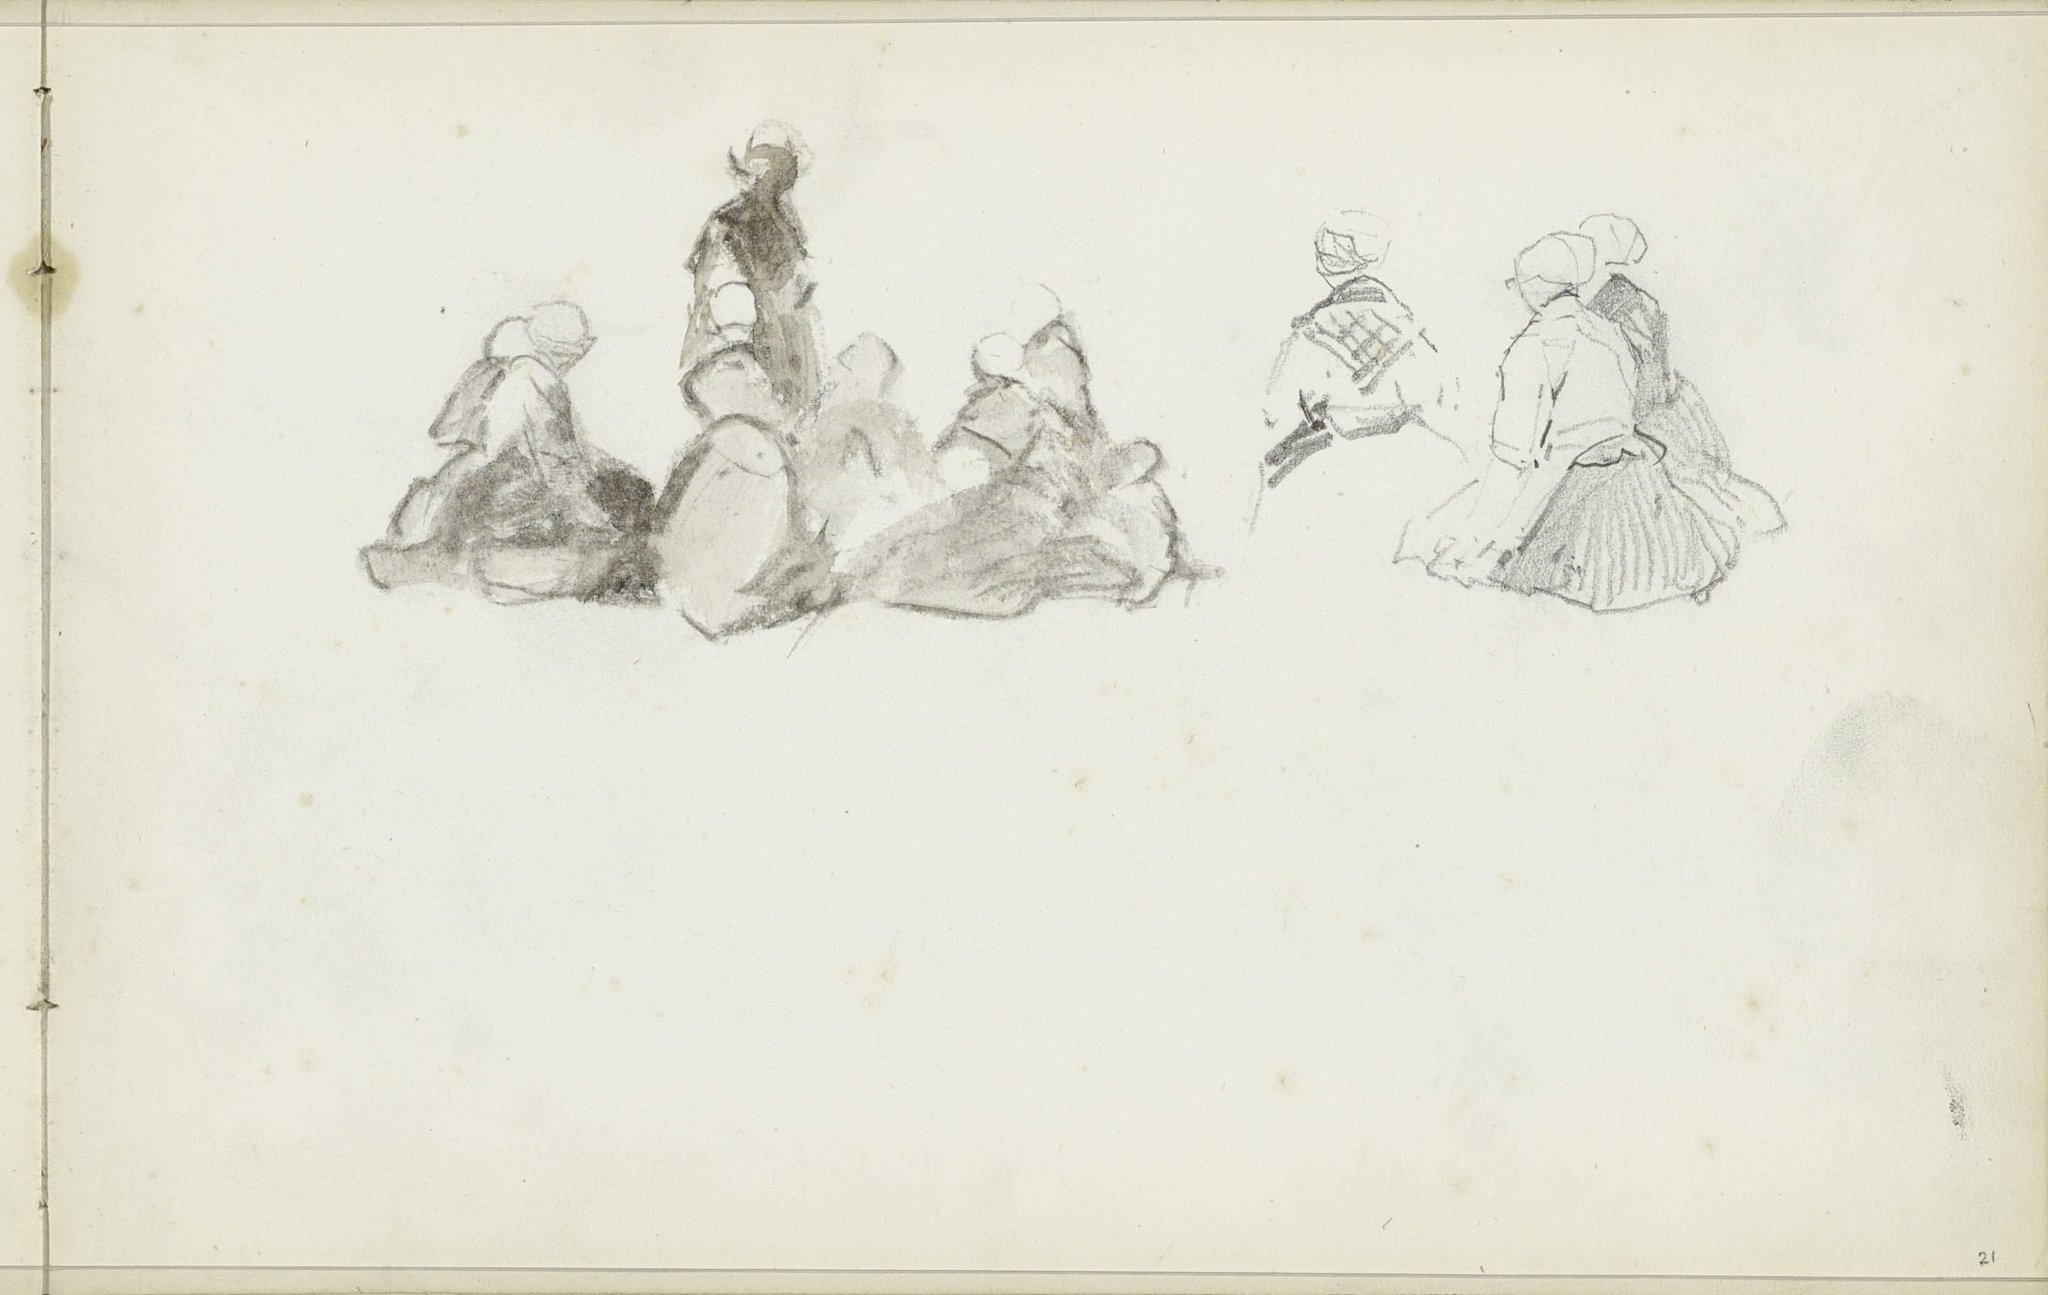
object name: sketchbook leaf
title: Groep zittende vrouwen in Scheveningse dracht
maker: johannes bosboom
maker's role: draughtsman, painter, print maker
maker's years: 1817-1891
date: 1873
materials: paper, pencil, watercolor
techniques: brush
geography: scheveningen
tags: folk costume, regional costume (+ women's clothes), sitting figure (+ female (human being) (not to be used where -aa- is prescribed))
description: Blad 21 recto uit een schetsboek met 39 bladen.